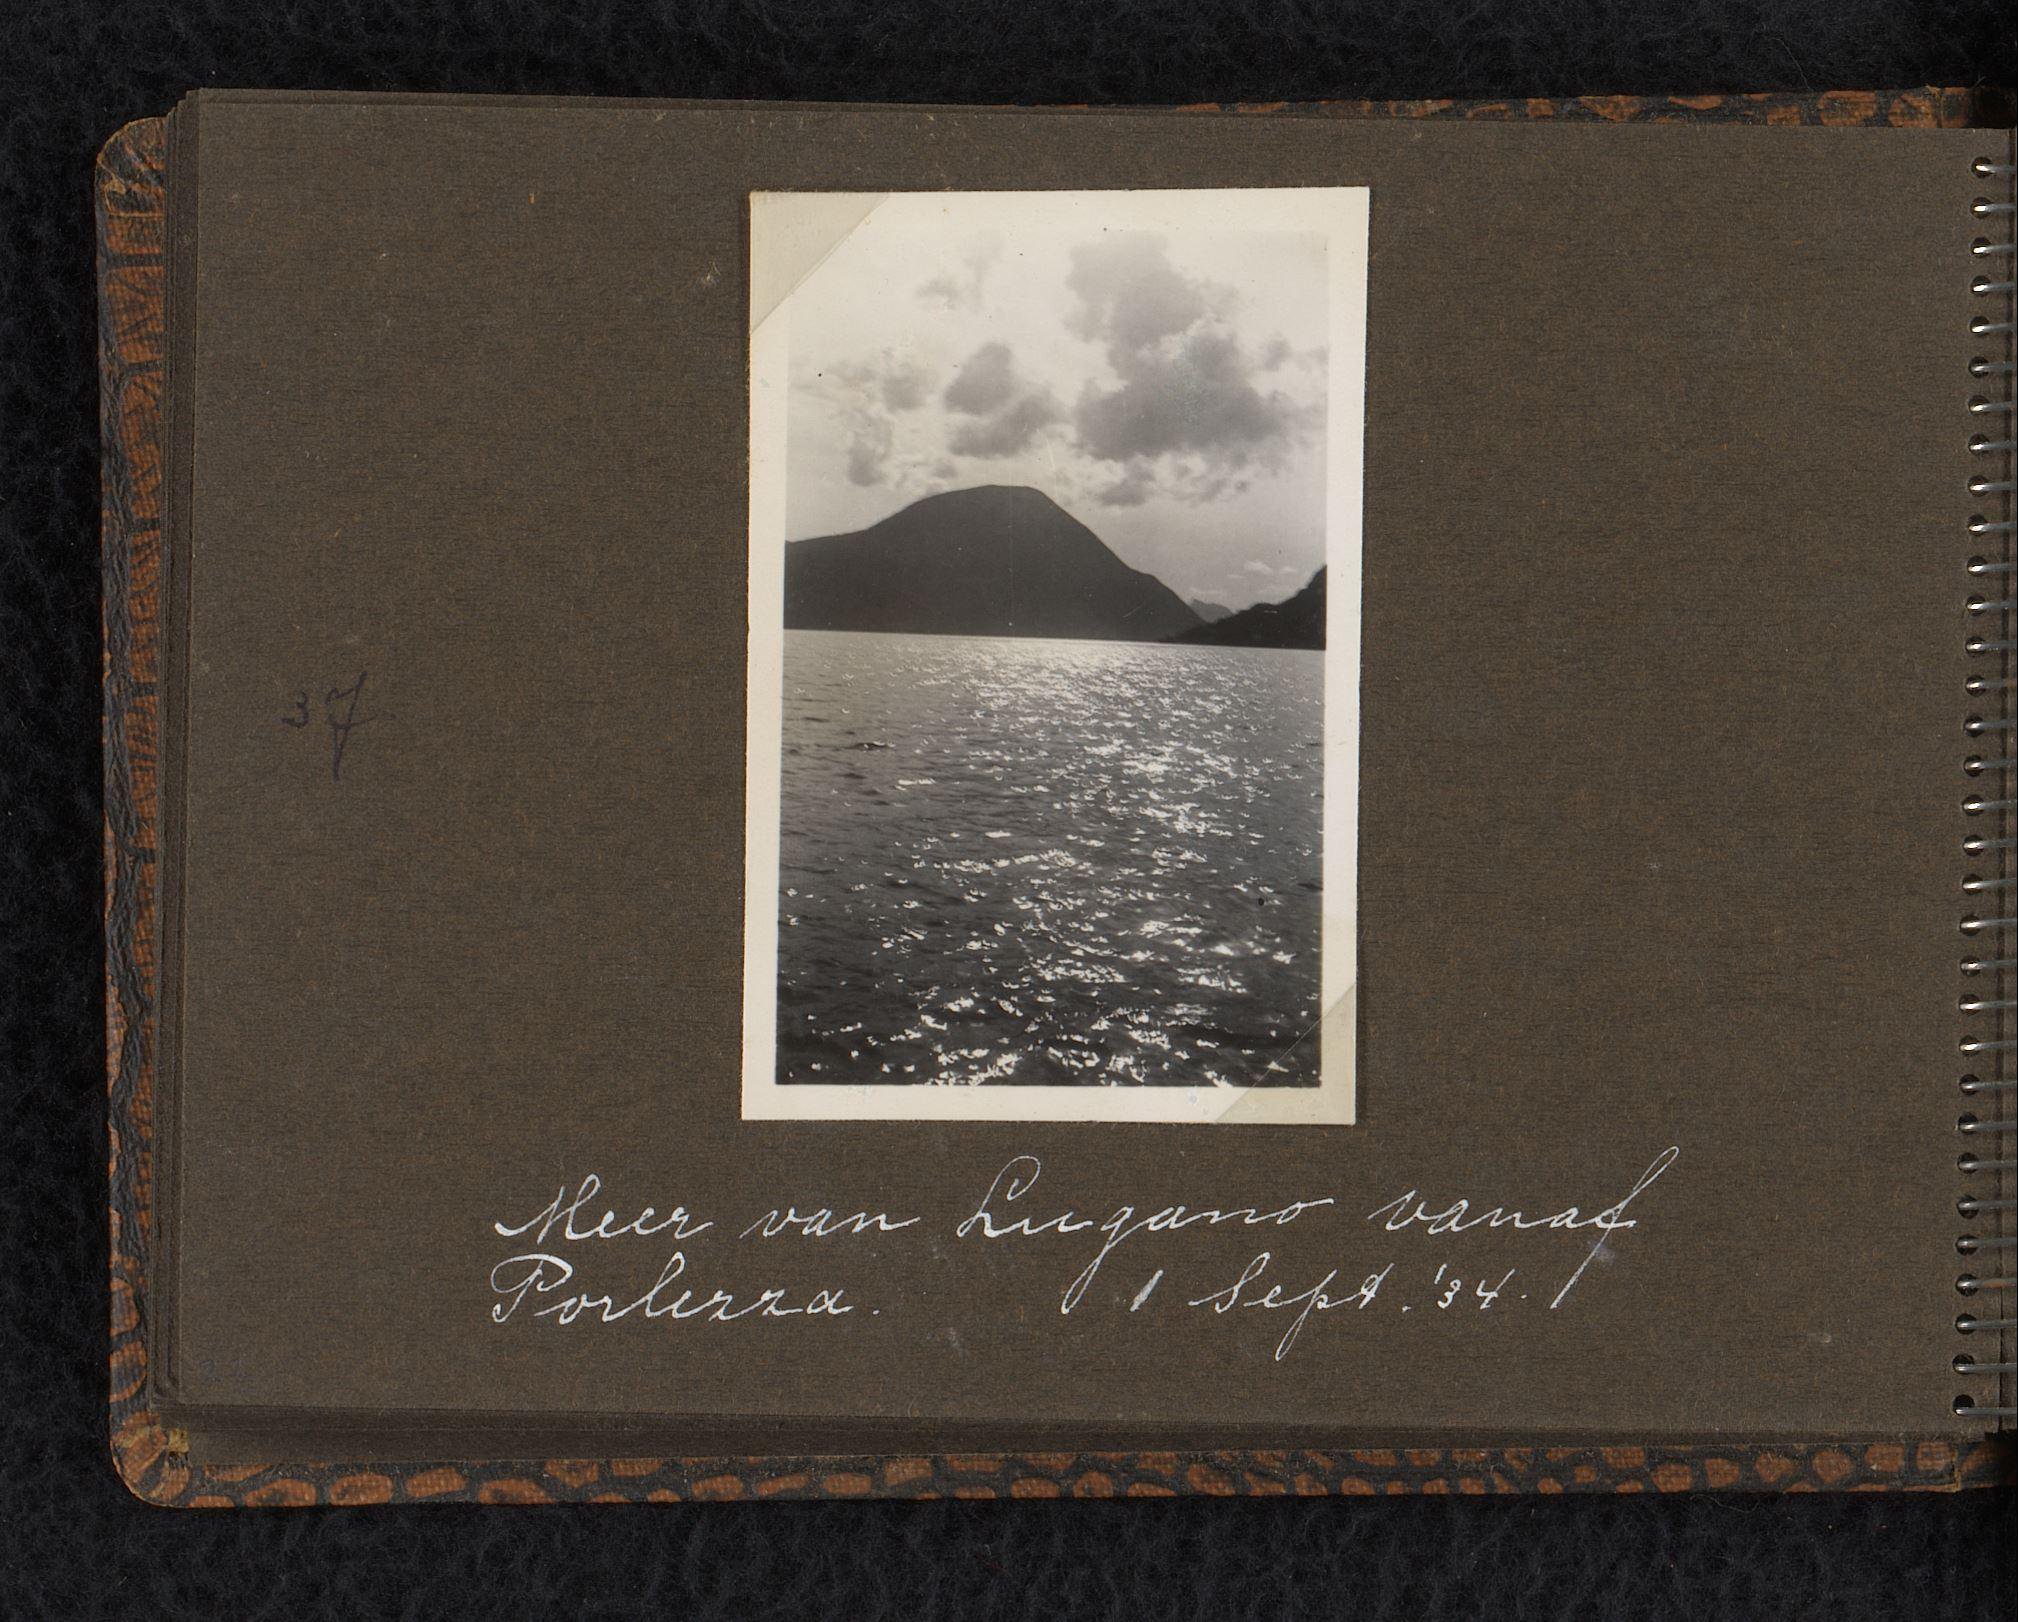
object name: photograph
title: Meer van Lugano vanaf Porlezza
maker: Anonymous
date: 1934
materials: paper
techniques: gelatin silver print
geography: porlezza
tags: lake, mountains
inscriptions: number: ‘37’